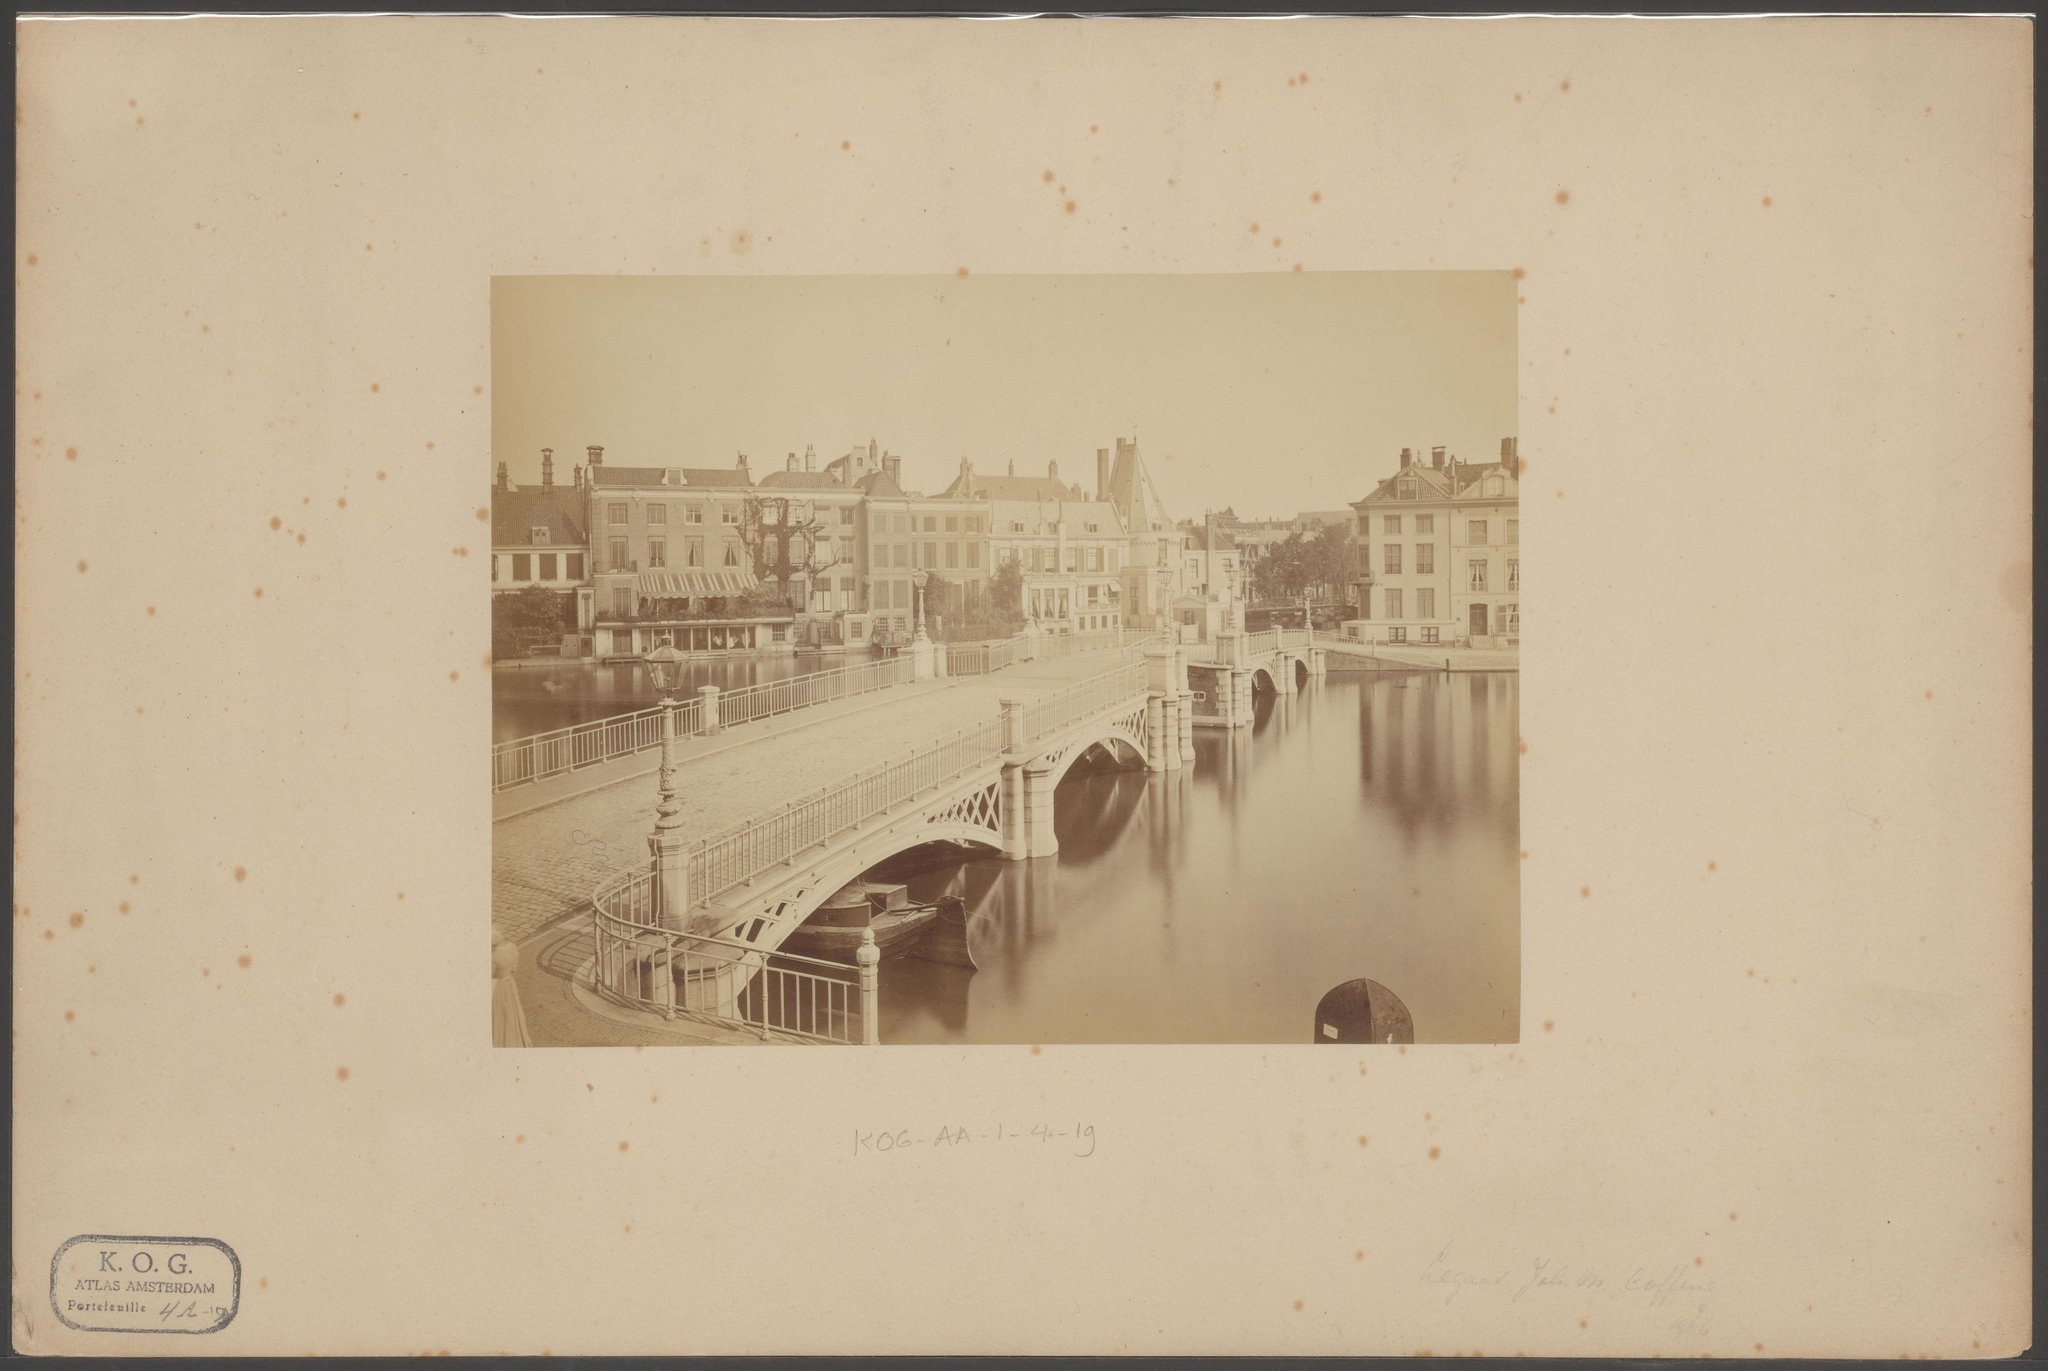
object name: photograph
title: Gezicht op de Halvemaansbrug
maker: Anonymous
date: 1863-1915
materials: cardboard, paper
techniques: albumen print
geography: amsterdam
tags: city-view in general; 'veduta', canal, bridge in city across river, canal, etc.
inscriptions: inscription: ‘Legaat Joh. M. Coffeng / 1966.’, collector's mark: ‘4A19’ Lugt 1641b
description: Onderwerpsrubriek binnen de Atlas Amsterdam: Amstel van Doelensluis tot Blauwbrug.